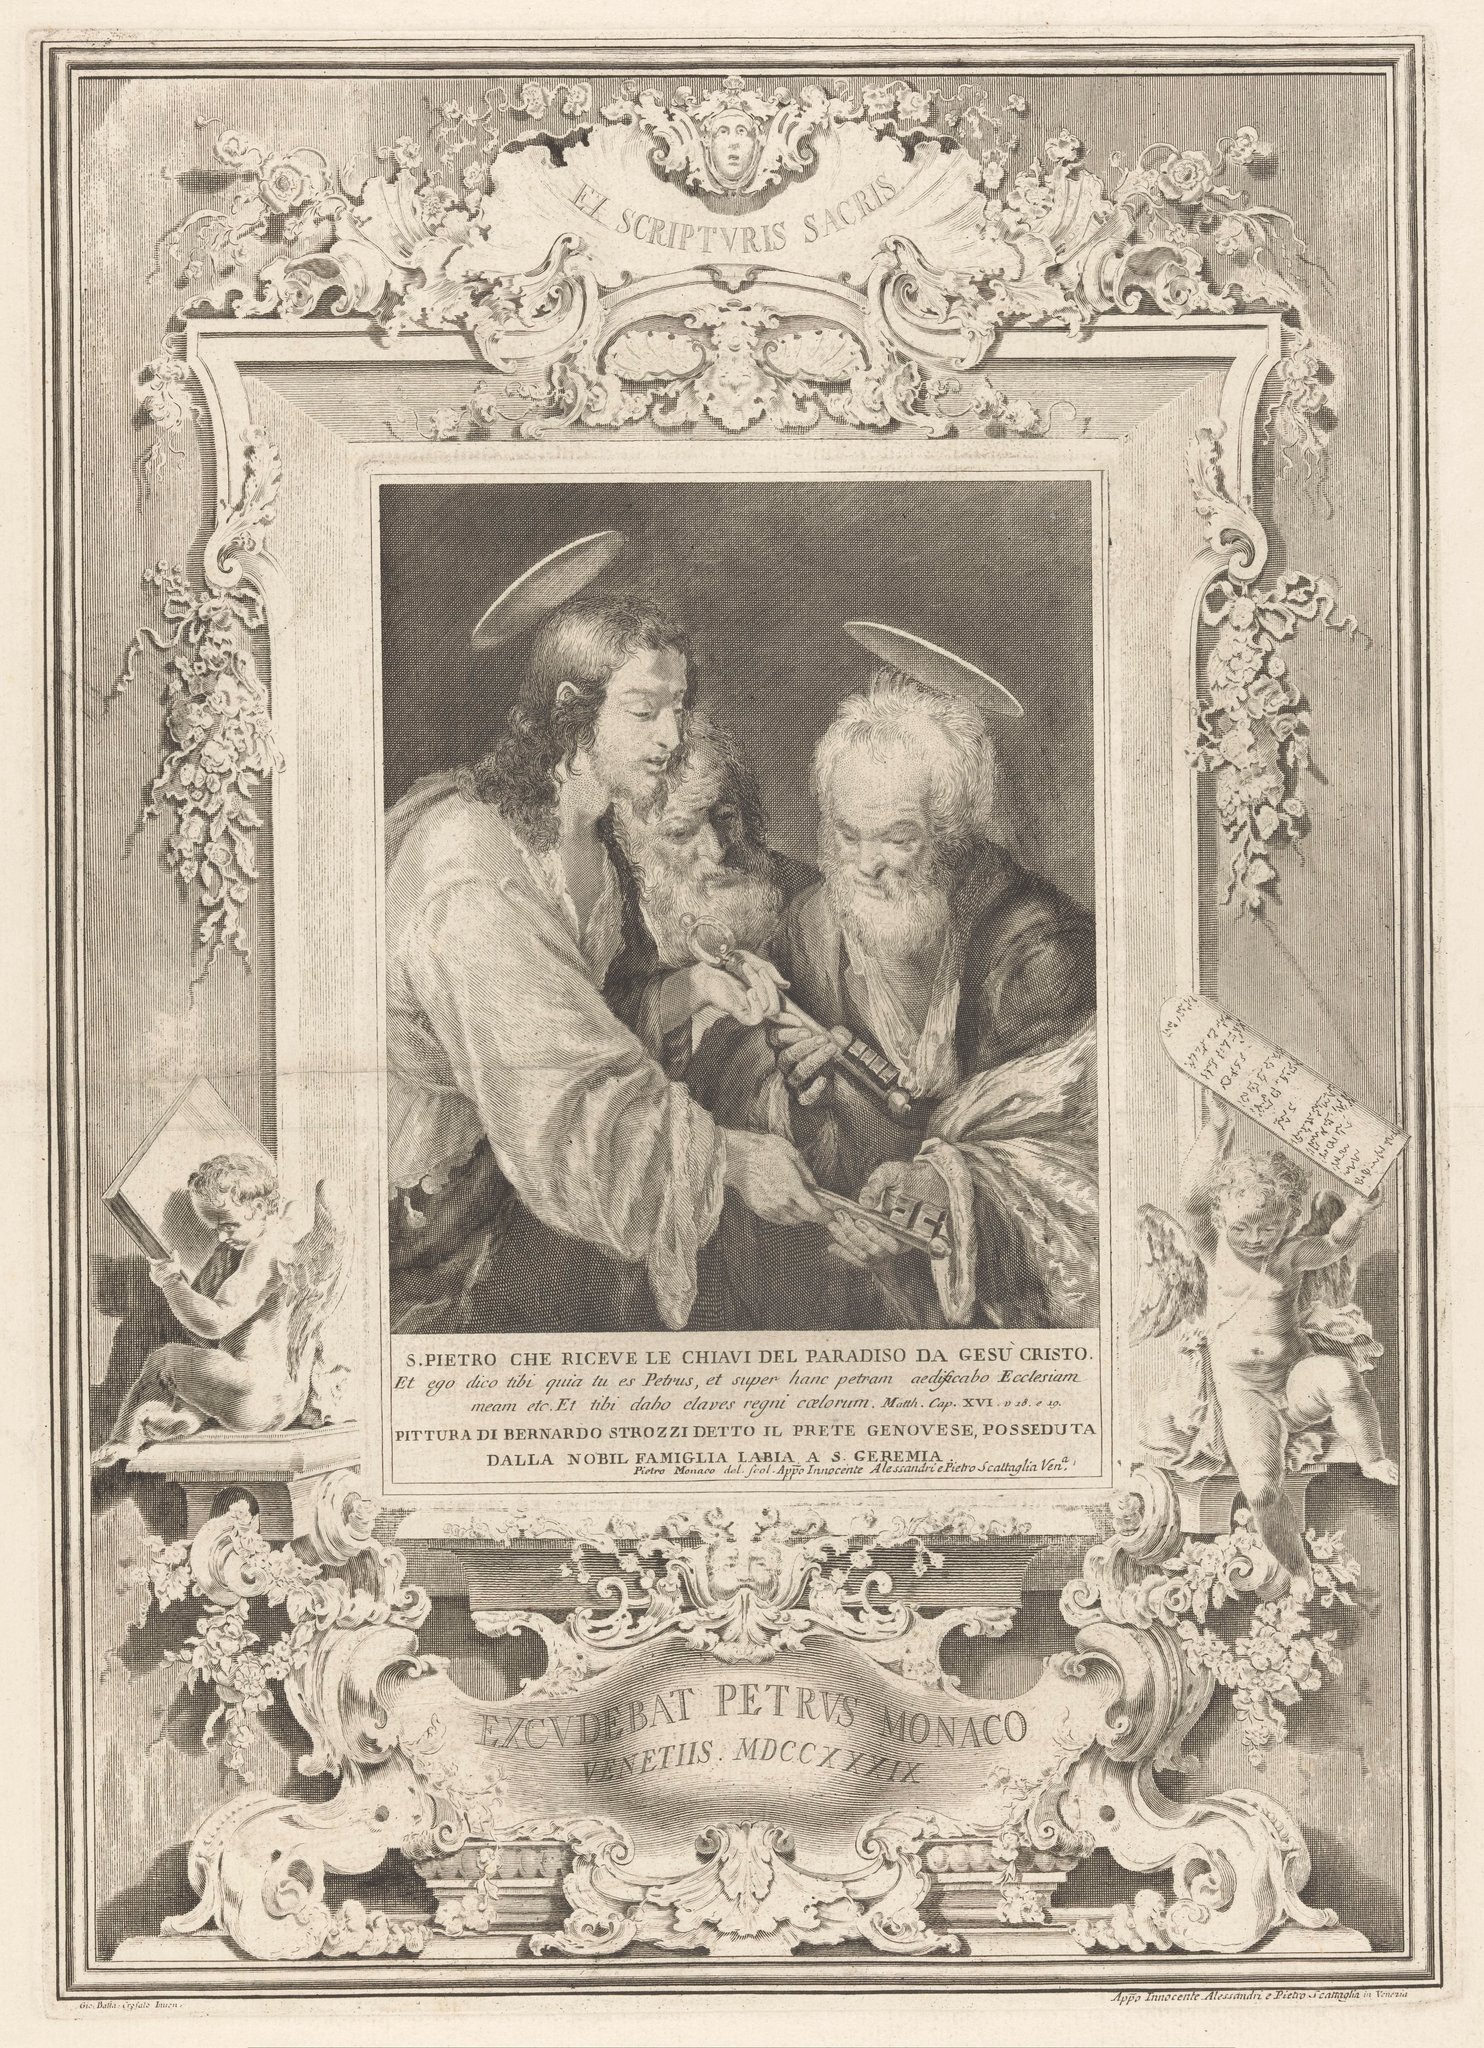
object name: print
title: S. Pietro che riceve le chiave del paradiso da Gesù Cristo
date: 1717-1763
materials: paper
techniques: etching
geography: italy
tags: christ gives the keys of heaven to peter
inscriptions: collector's mark: Lugt 2228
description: Petrus ontvangt de sleutels van de hemelpoort van Christus. De voorstelling is gevat in een sierlijst met twee putti en ornament.